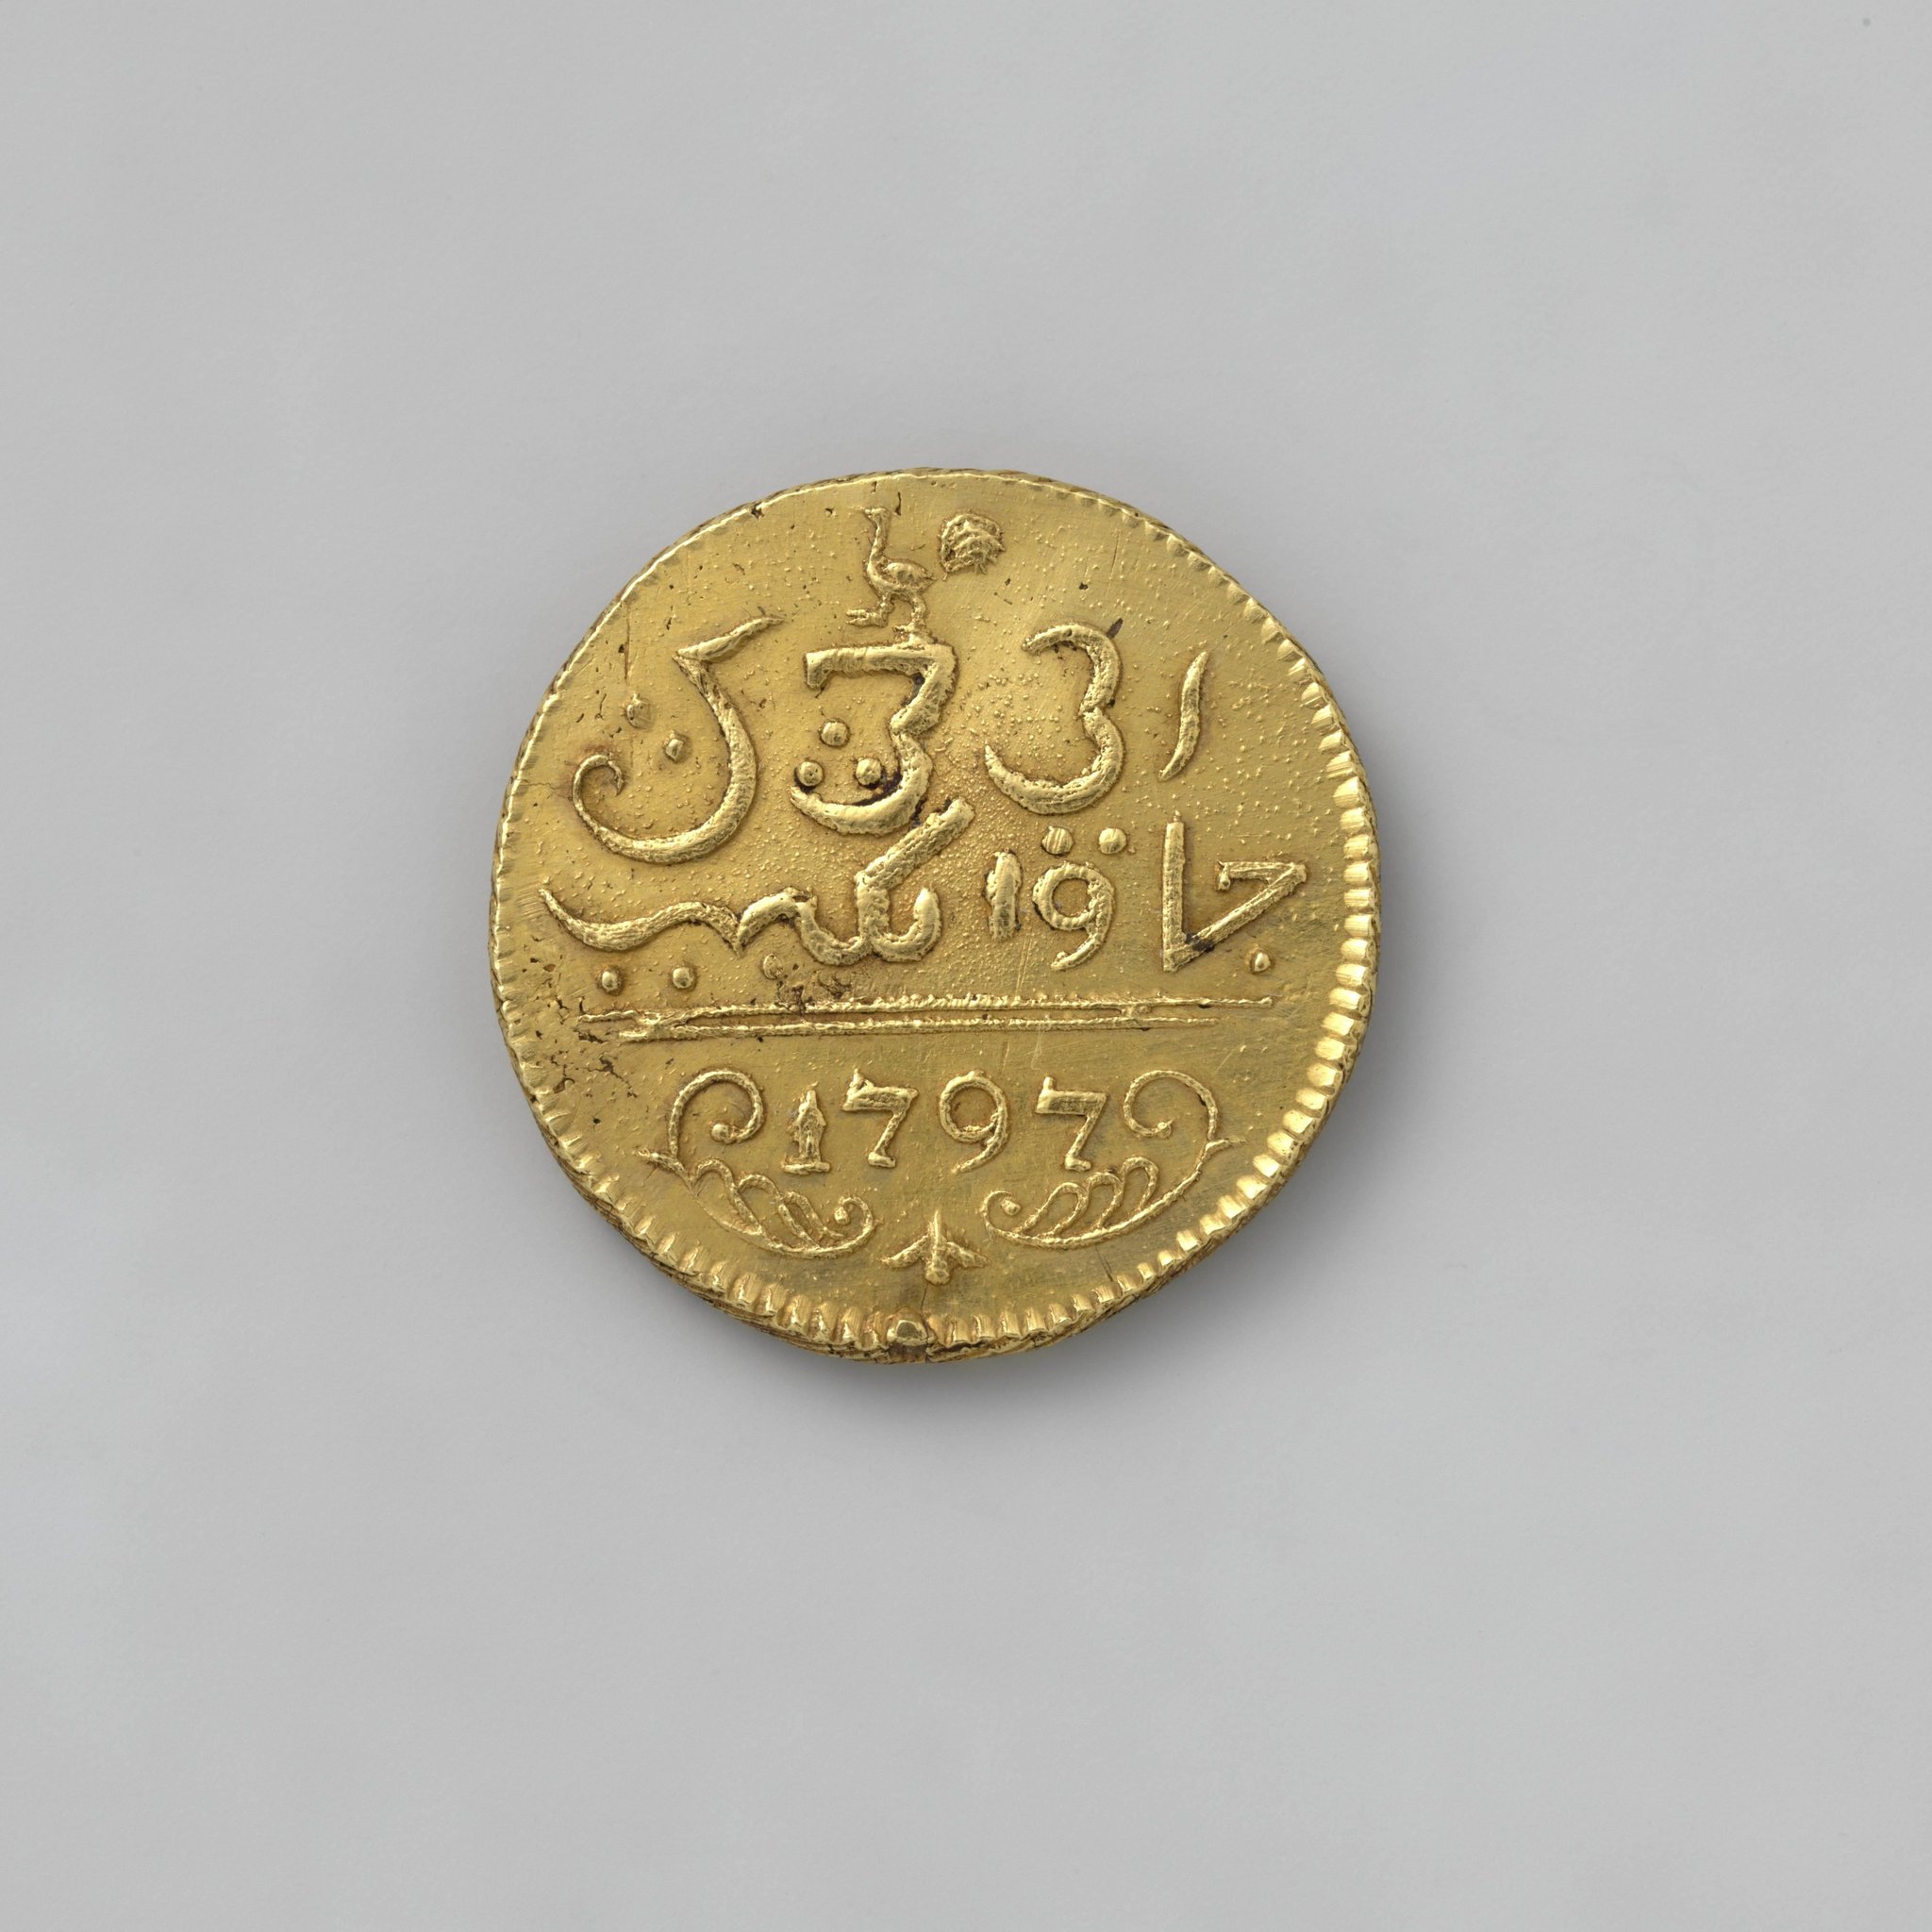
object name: coin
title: VOC, gouden Javase ropij, 1797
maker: f.a. van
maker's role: mintmaster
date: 1797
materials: gold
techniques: striking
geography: batavia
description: Gouden munt. Voorzijde: tweeregelig opschrift in Arabische letters. Daarboven muntmeesterteken en daaronder dubbellijnige balk, waaronder jaartal in versiering. Keerzijde: drieregelig opschrift in Arabische letters. Daarboven en daaronder een touwstrik. Kabelrand.